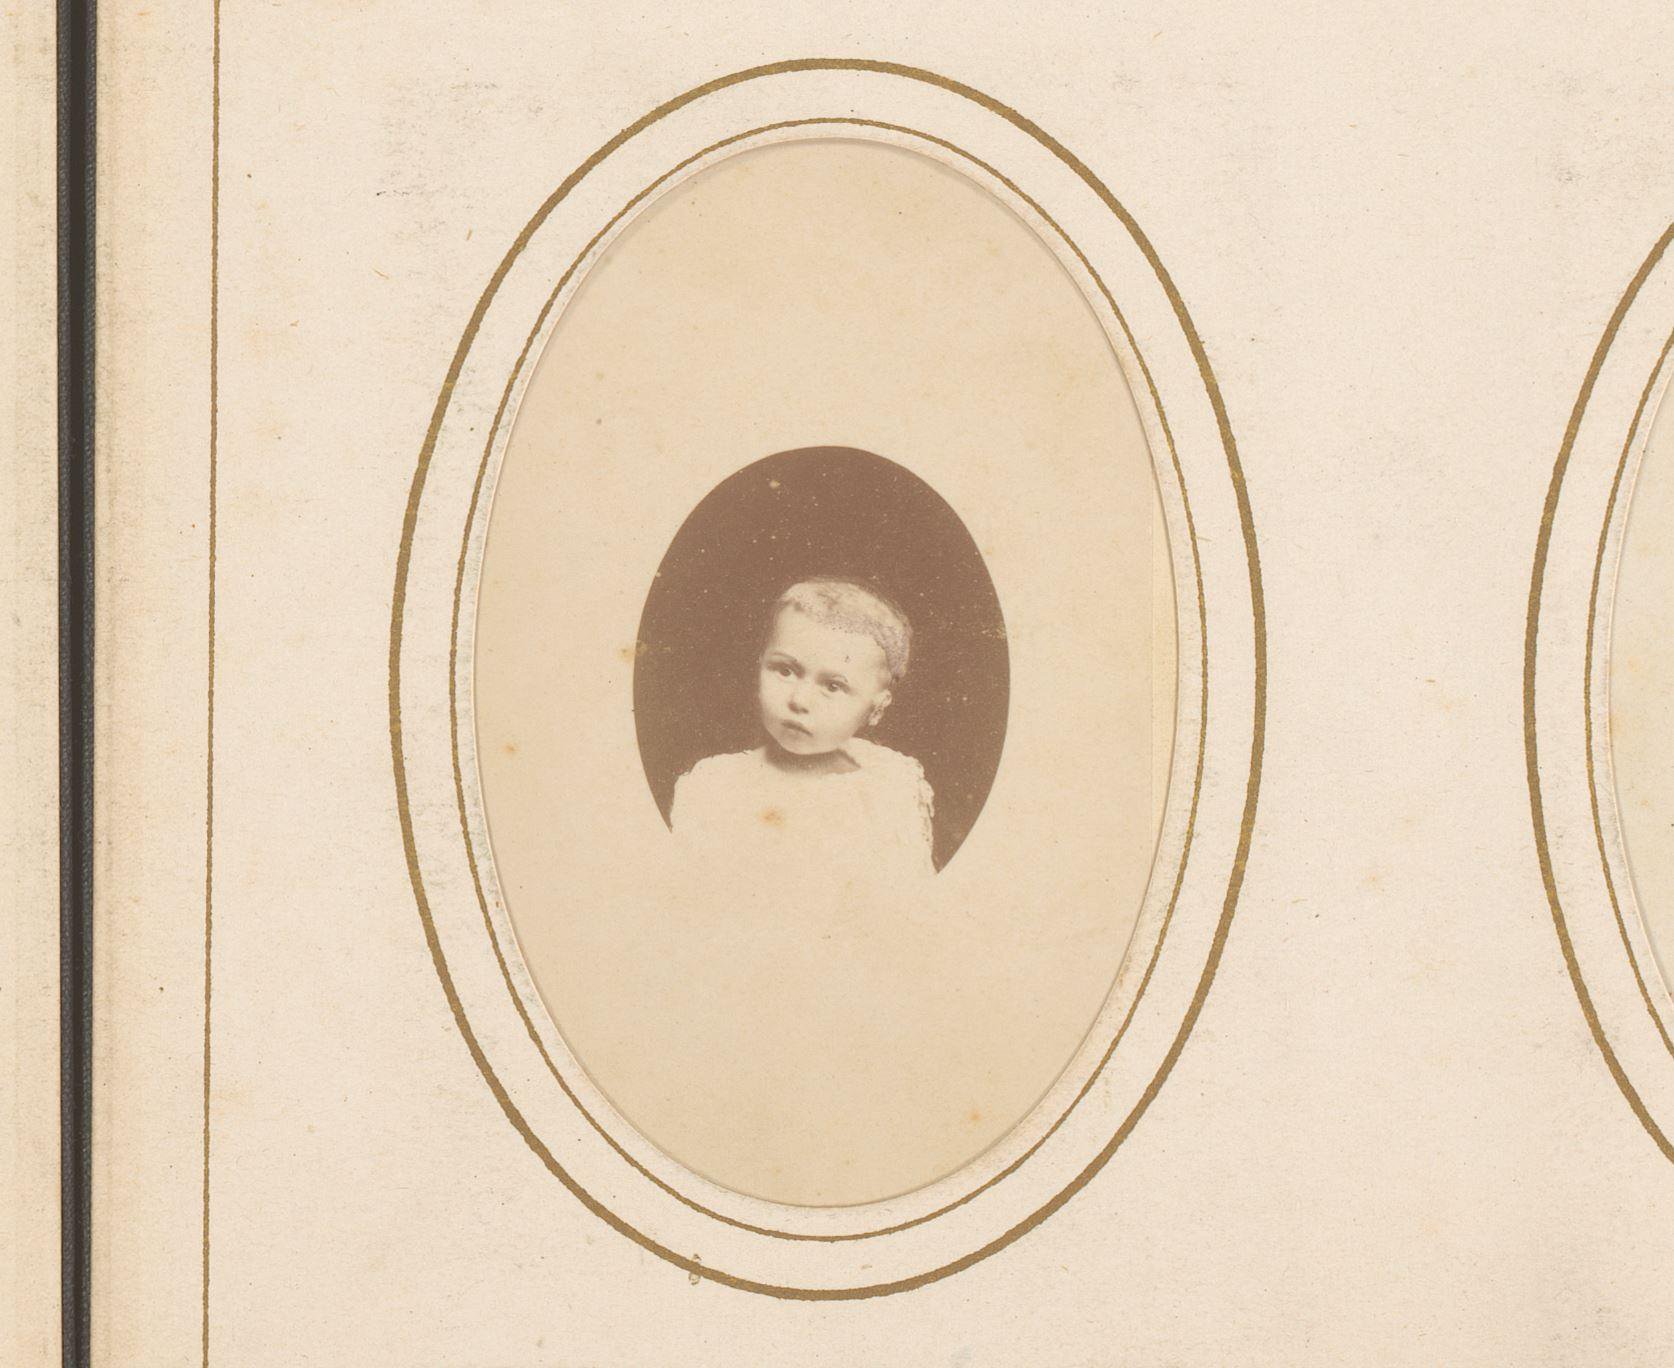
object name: album leaf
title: Portret van een kind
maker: albert delabarre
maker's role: musician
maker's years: 1809-1885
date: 1860-1900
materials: cardboard, photographic support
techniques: albumen print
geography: brussels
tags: child, historical persons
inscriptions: inscription: ‘PHOTOGRAPHIE PARISIENNE/ 18, Rue Fossé aux Loups, 18/ (Place de la Monnaie)/ BRUXELLES/ Les clichés sont conservés.’